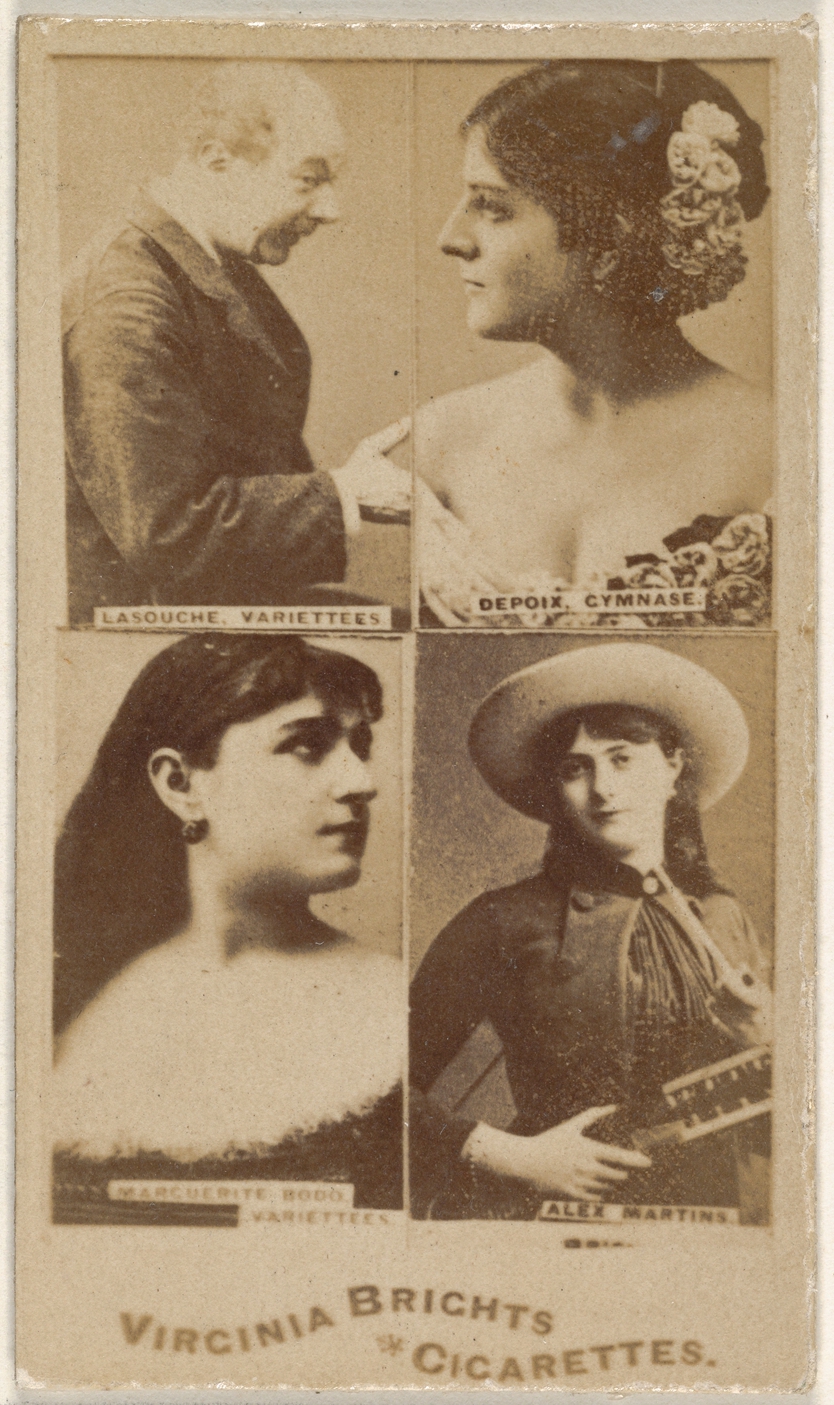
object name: photograph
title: Lasouche, Variettees/ Depoix, Gymnase/ Marguerite Hood, Variettees/ Alex Martins, from the Actors and Actresses series (N45, Type 4) for Virginia Brights Cigarettes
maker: allen & ginter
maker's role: publisher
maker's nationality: american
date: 1888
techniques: albumen silver print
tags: men,women,actors,actresses